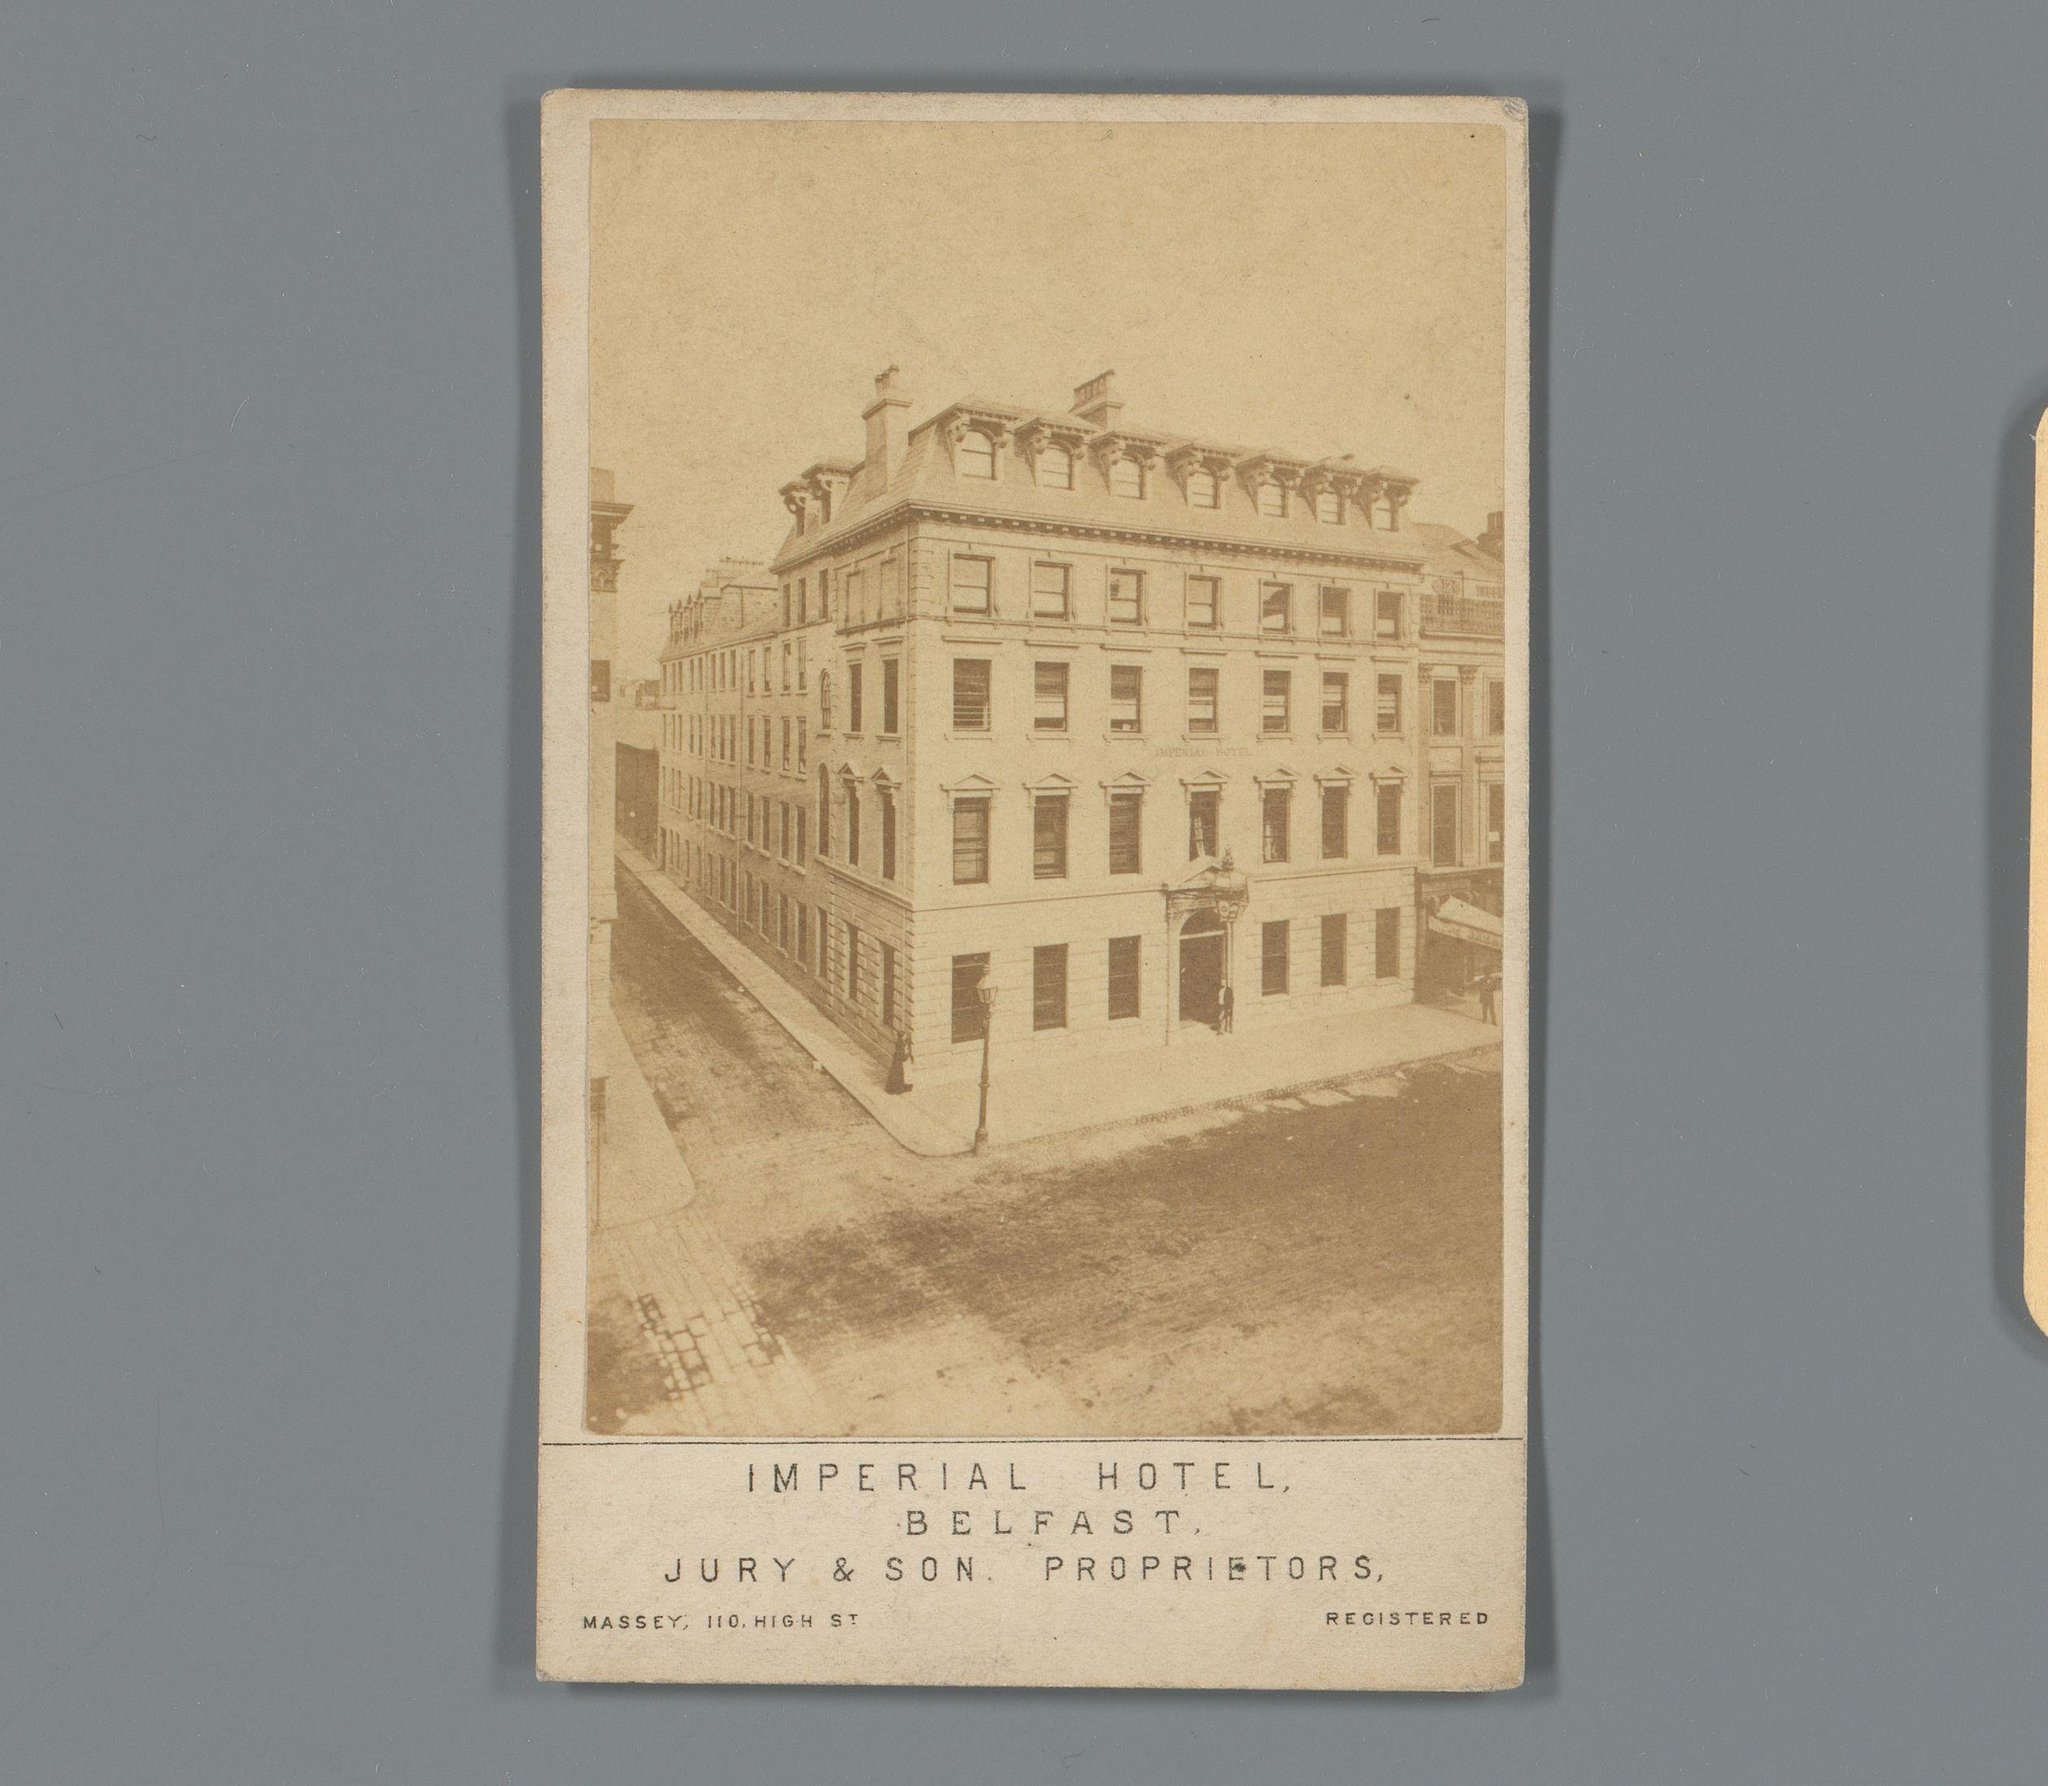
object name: carte de visite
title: Gezicht op voormalig Imperial Hotel in Belfast, Noord-Ierland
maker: joseph massey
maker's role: fotograaf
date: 1850-1915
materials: cardboard, photographic support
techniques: albumen print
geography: belfast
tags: advertising, hotel, hostelry, inn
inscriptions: inscription: ‘MASSEY, 110 HIGH ST REGISTERED’